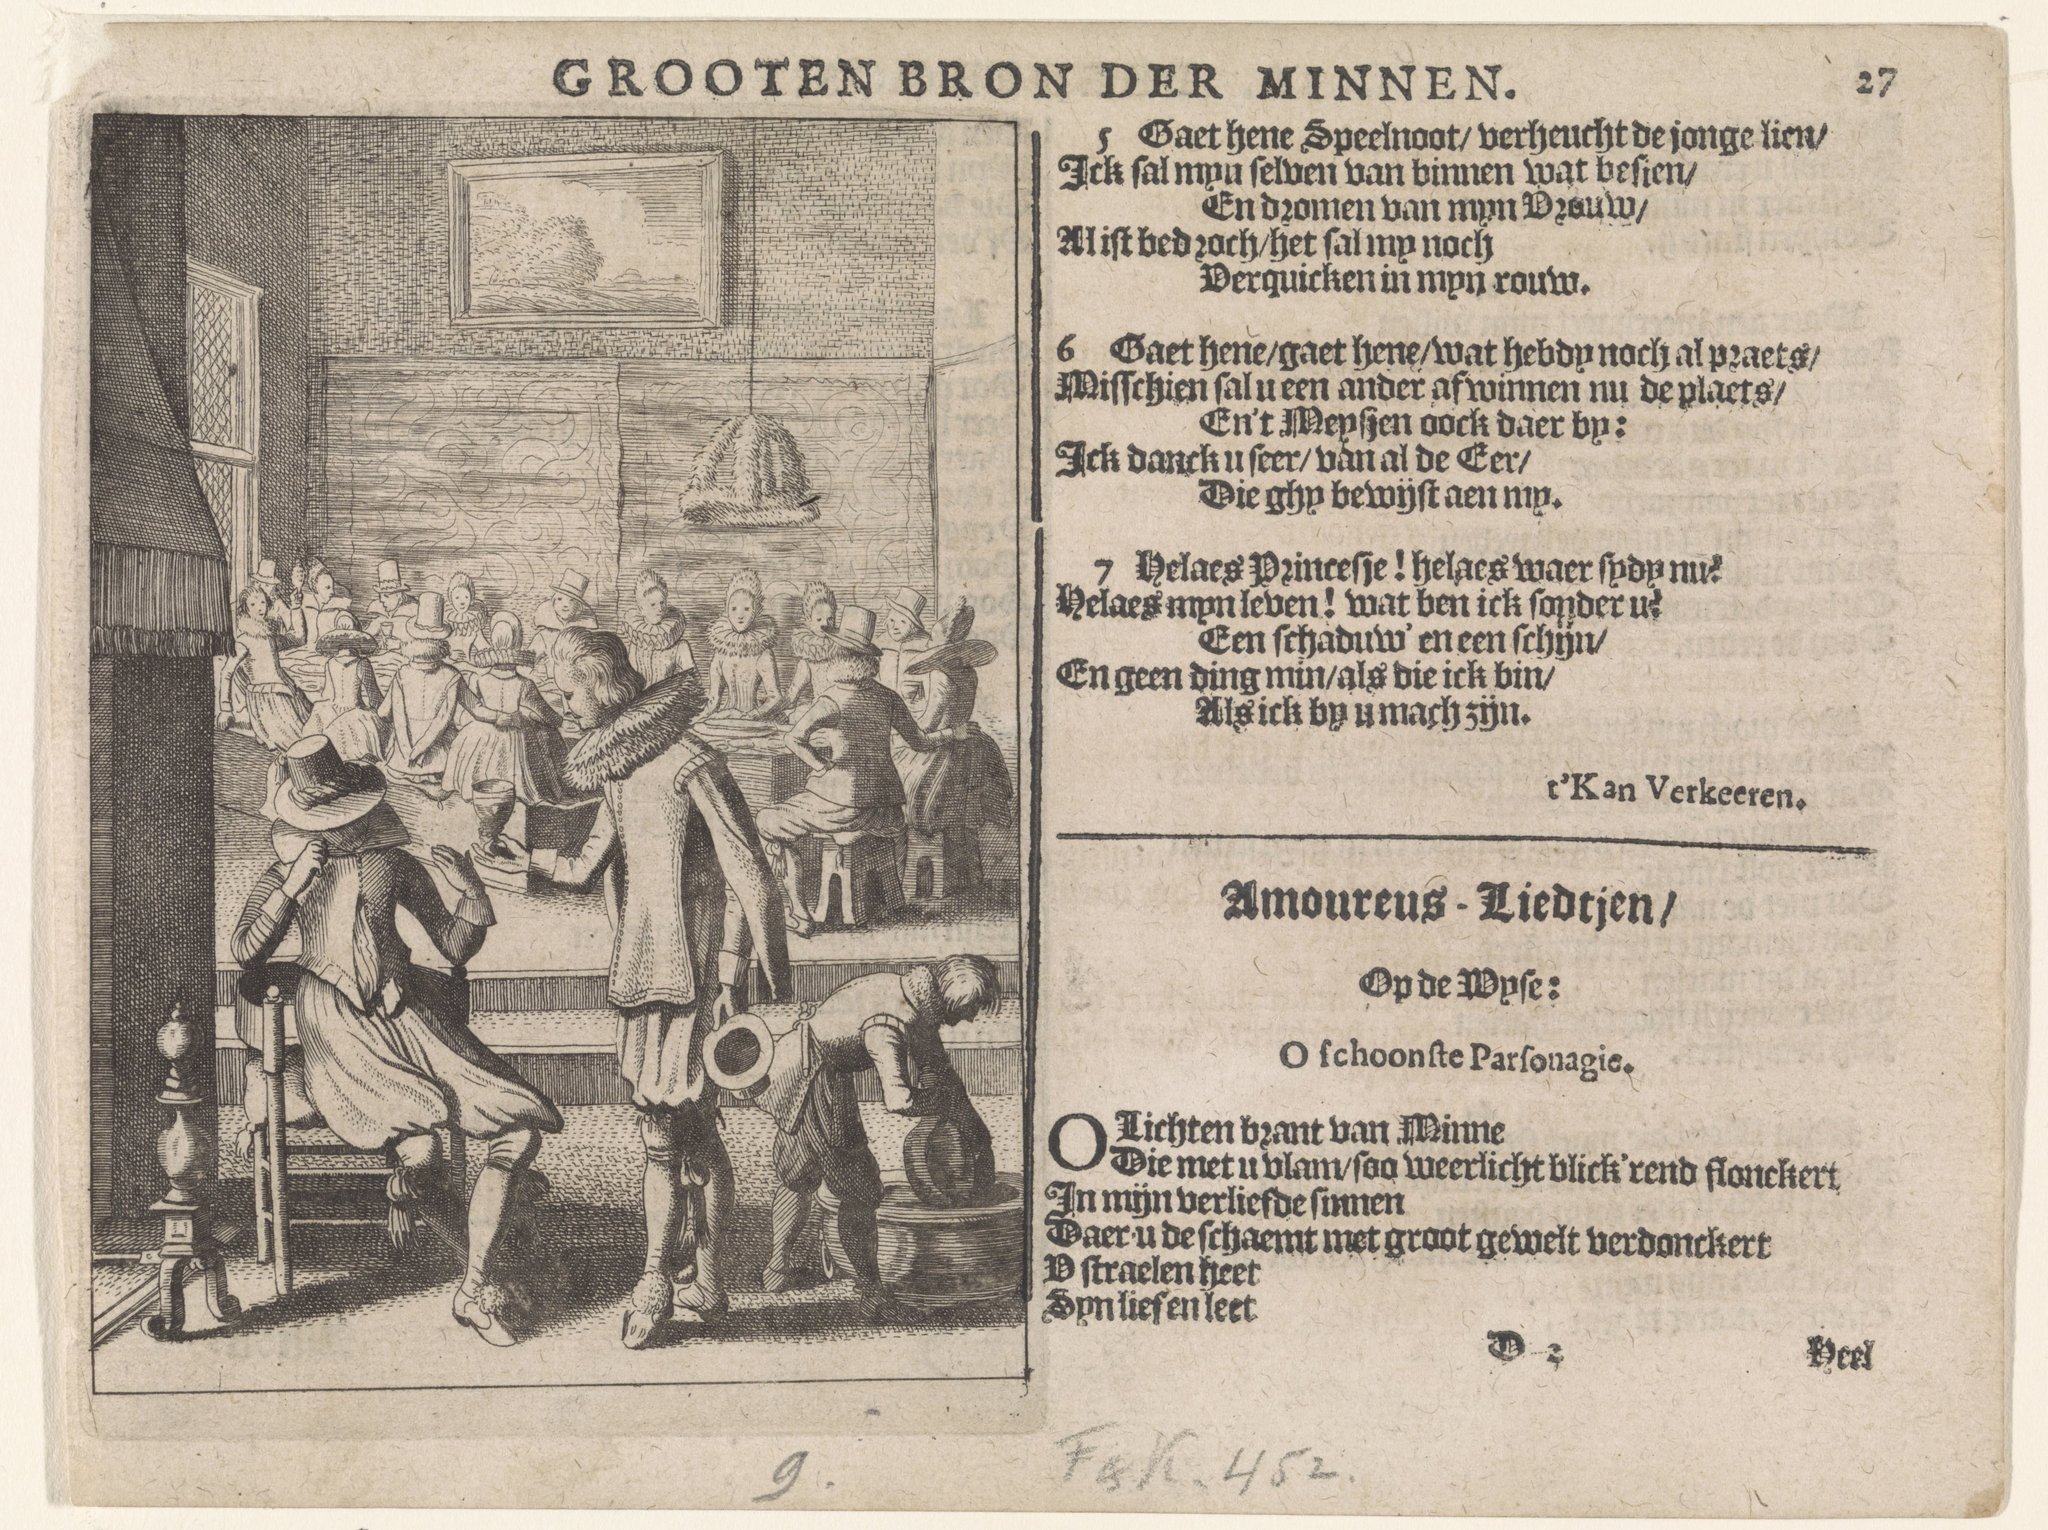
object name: print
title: Amoureus-Liedtjen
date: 1622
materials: paper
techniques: etching, letterpress printing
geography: amsterdam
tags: giving drink, hand(s) bent towards the head, banquet of elegant company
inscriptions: collector's mark: Lugt 964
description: Een man in teleurgestelde houding heeft zich afgezonderd van een etend en drinkend gezelschap aan een tafel op de achtergrond. Naast hem staat en jonge, elegant geklede man die hem een glas aanbiedt. Boekillustratie uit G.A. Bredero, Boertigh, amoreus, en aendachtigh groot lied-boeck, 1622. Rechtsboven paginanummer 27.